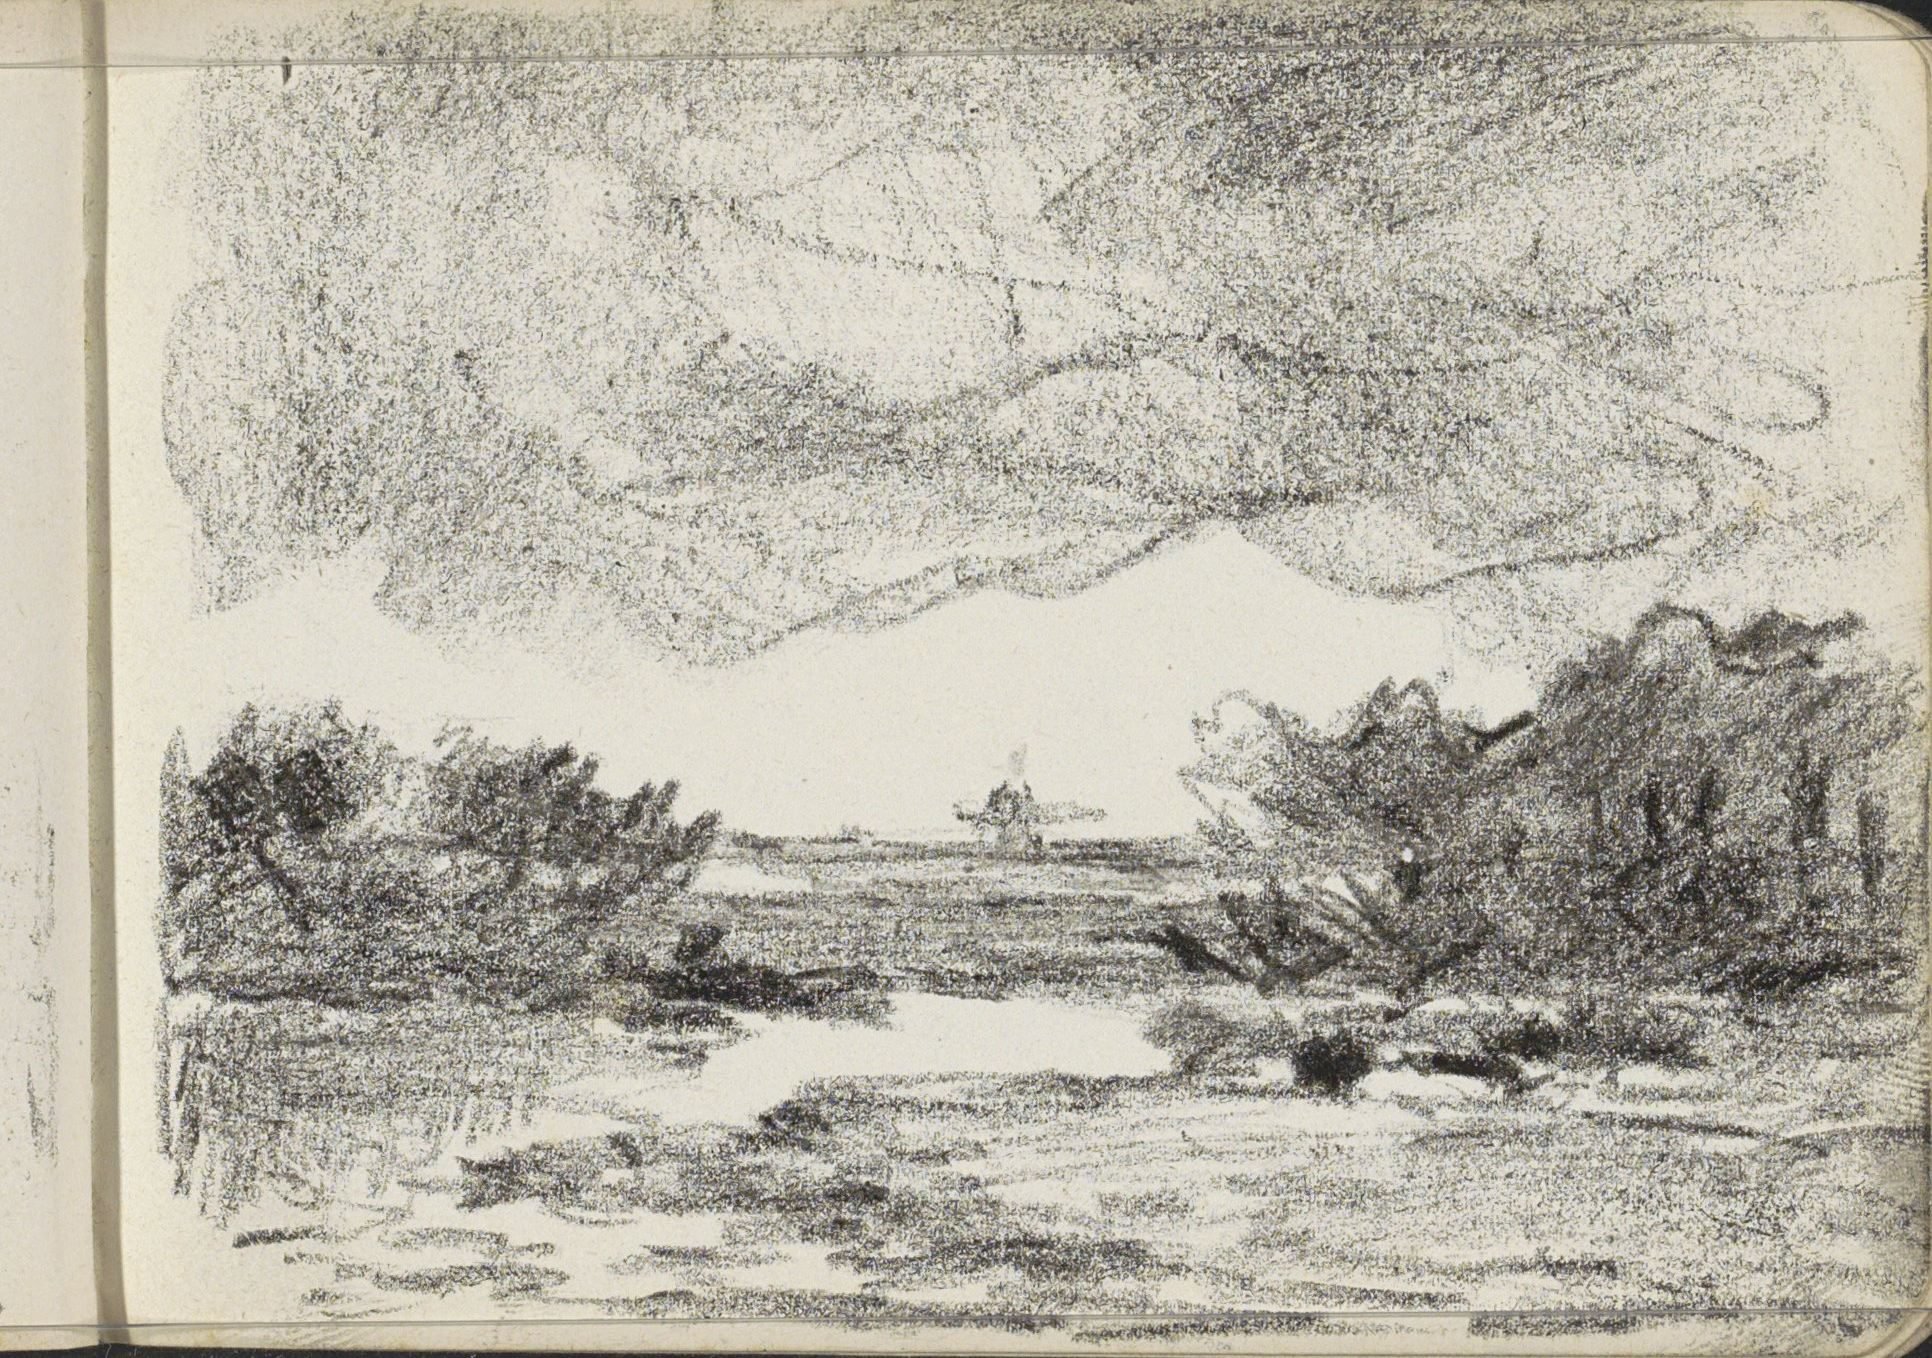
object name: sketchbook leaf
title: Landschap met water en een molen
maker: willem cornelis rip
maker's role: draughtsman, painter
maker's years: 1856-1922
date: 1907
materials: chalk, paper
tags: landscapes with waters, waterscapes, seascapes (in the temperate zone), windmill in landscape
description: Blad 21 recto uit een schetsboek met 41 bladen.